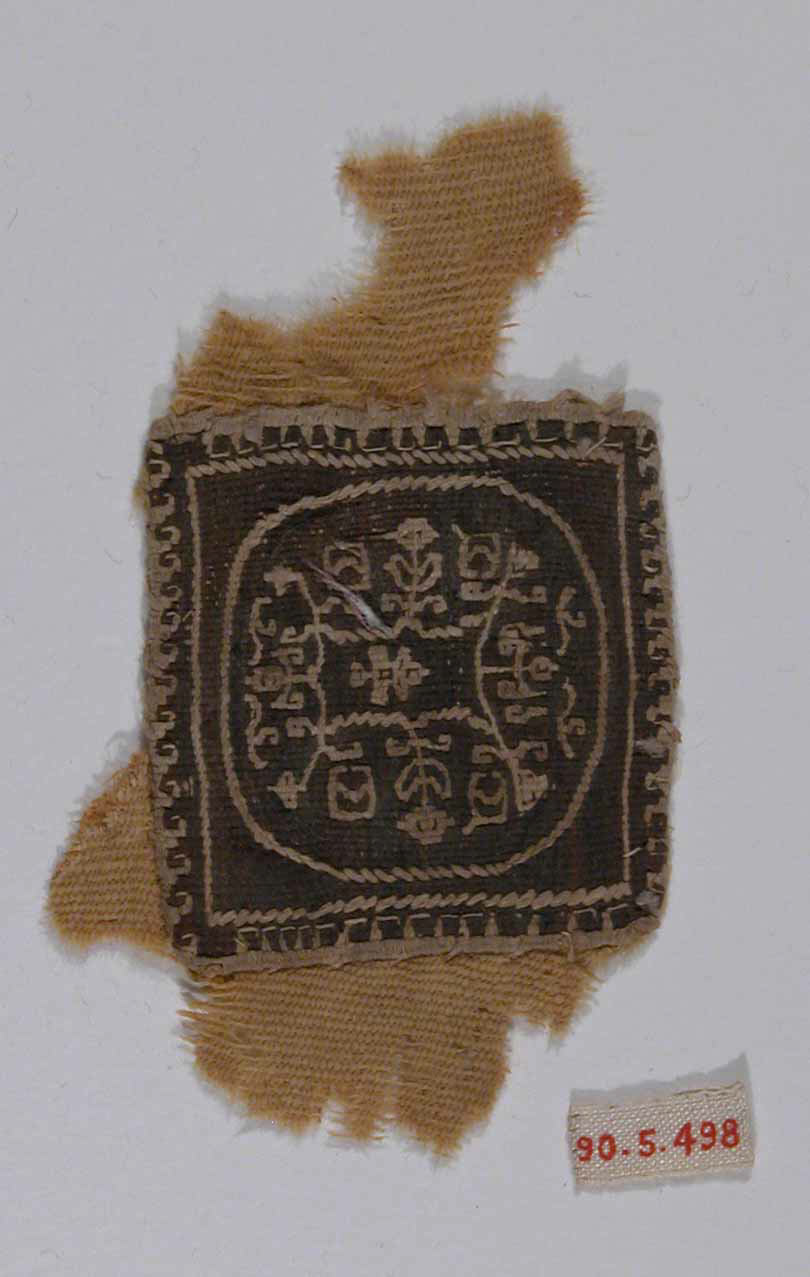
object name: textile fragment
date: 301-400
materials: linen, wool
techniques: weave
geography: egypt